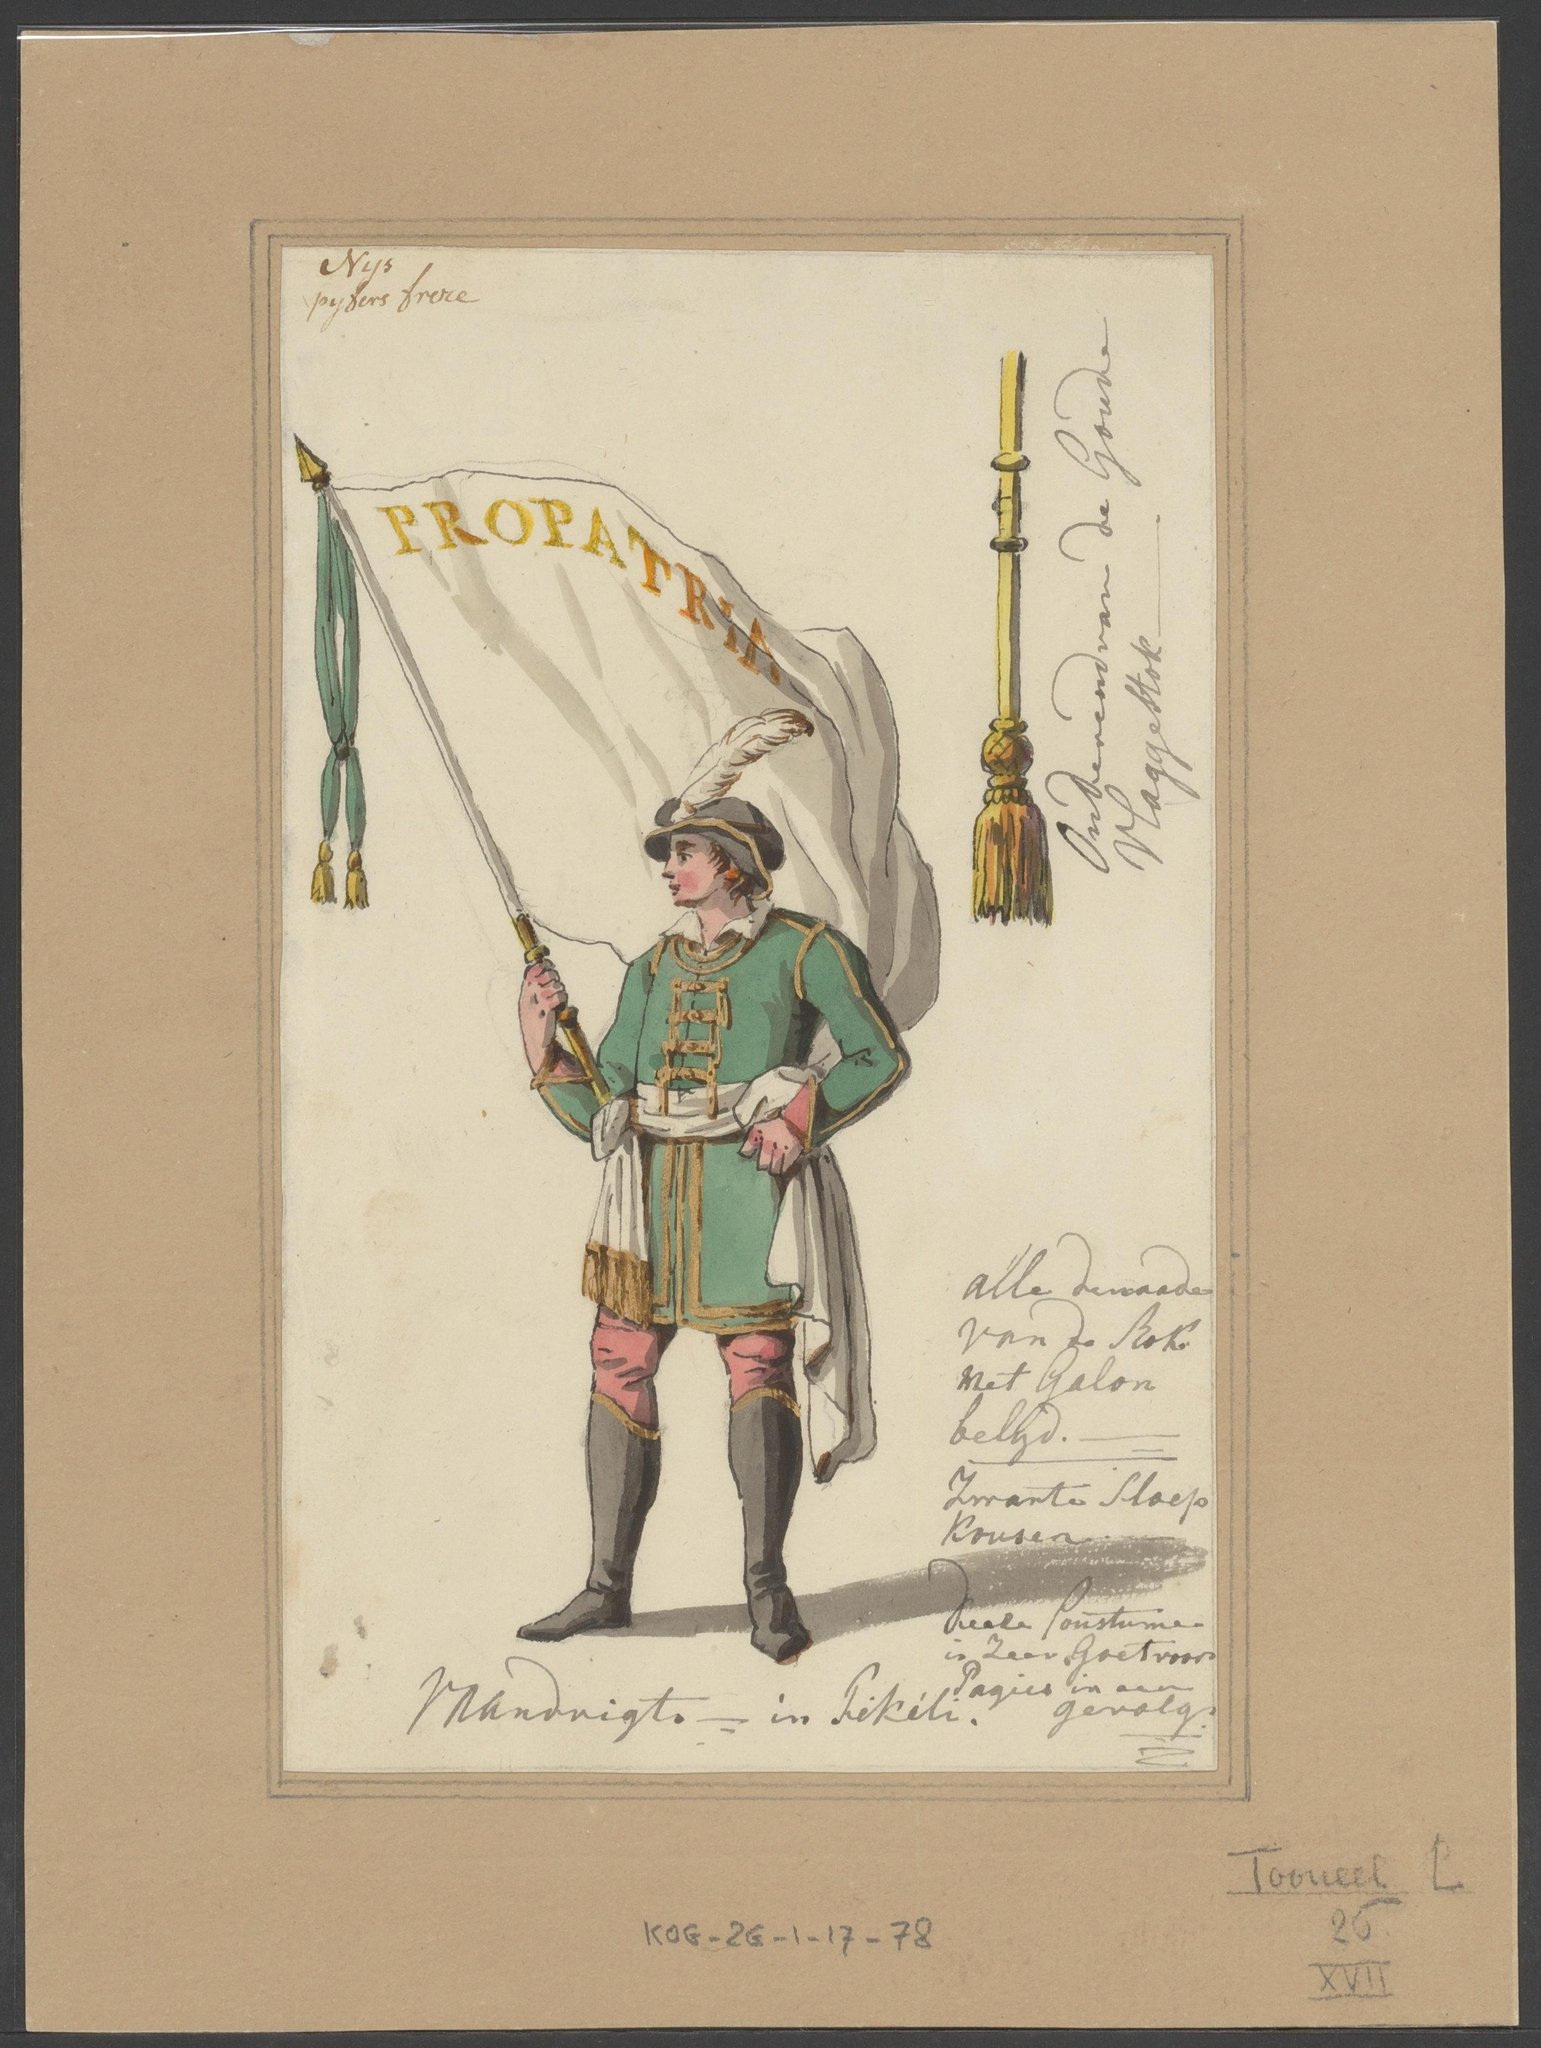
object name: drawing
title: Theaterkostuum voor een vaandeldrager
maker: Anonymous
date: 1807-1812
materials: ink, paper, watercolor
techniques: brush, pen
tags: stage costume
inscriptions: stamp, collector's mark: Lugt 1641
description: Theaterkostuum voor een vaandeldrager voor in het toneelstuk Tekeli geschreven door Theodore Hook. De voorstelling is opgevoerd in 1807 en 1812. Onderwerpsrubrieken binnen de Atlas Zeden en Gewoonten: Tooneel, Ontwerpen costumes.